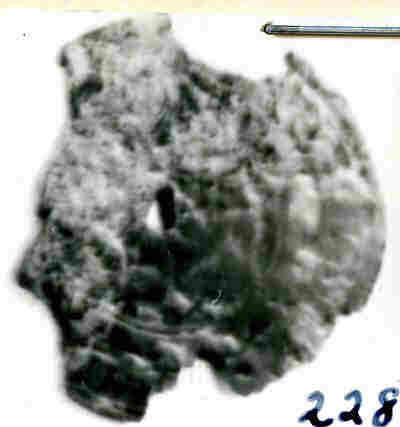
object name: coin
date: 801-1100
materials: copper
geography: iran